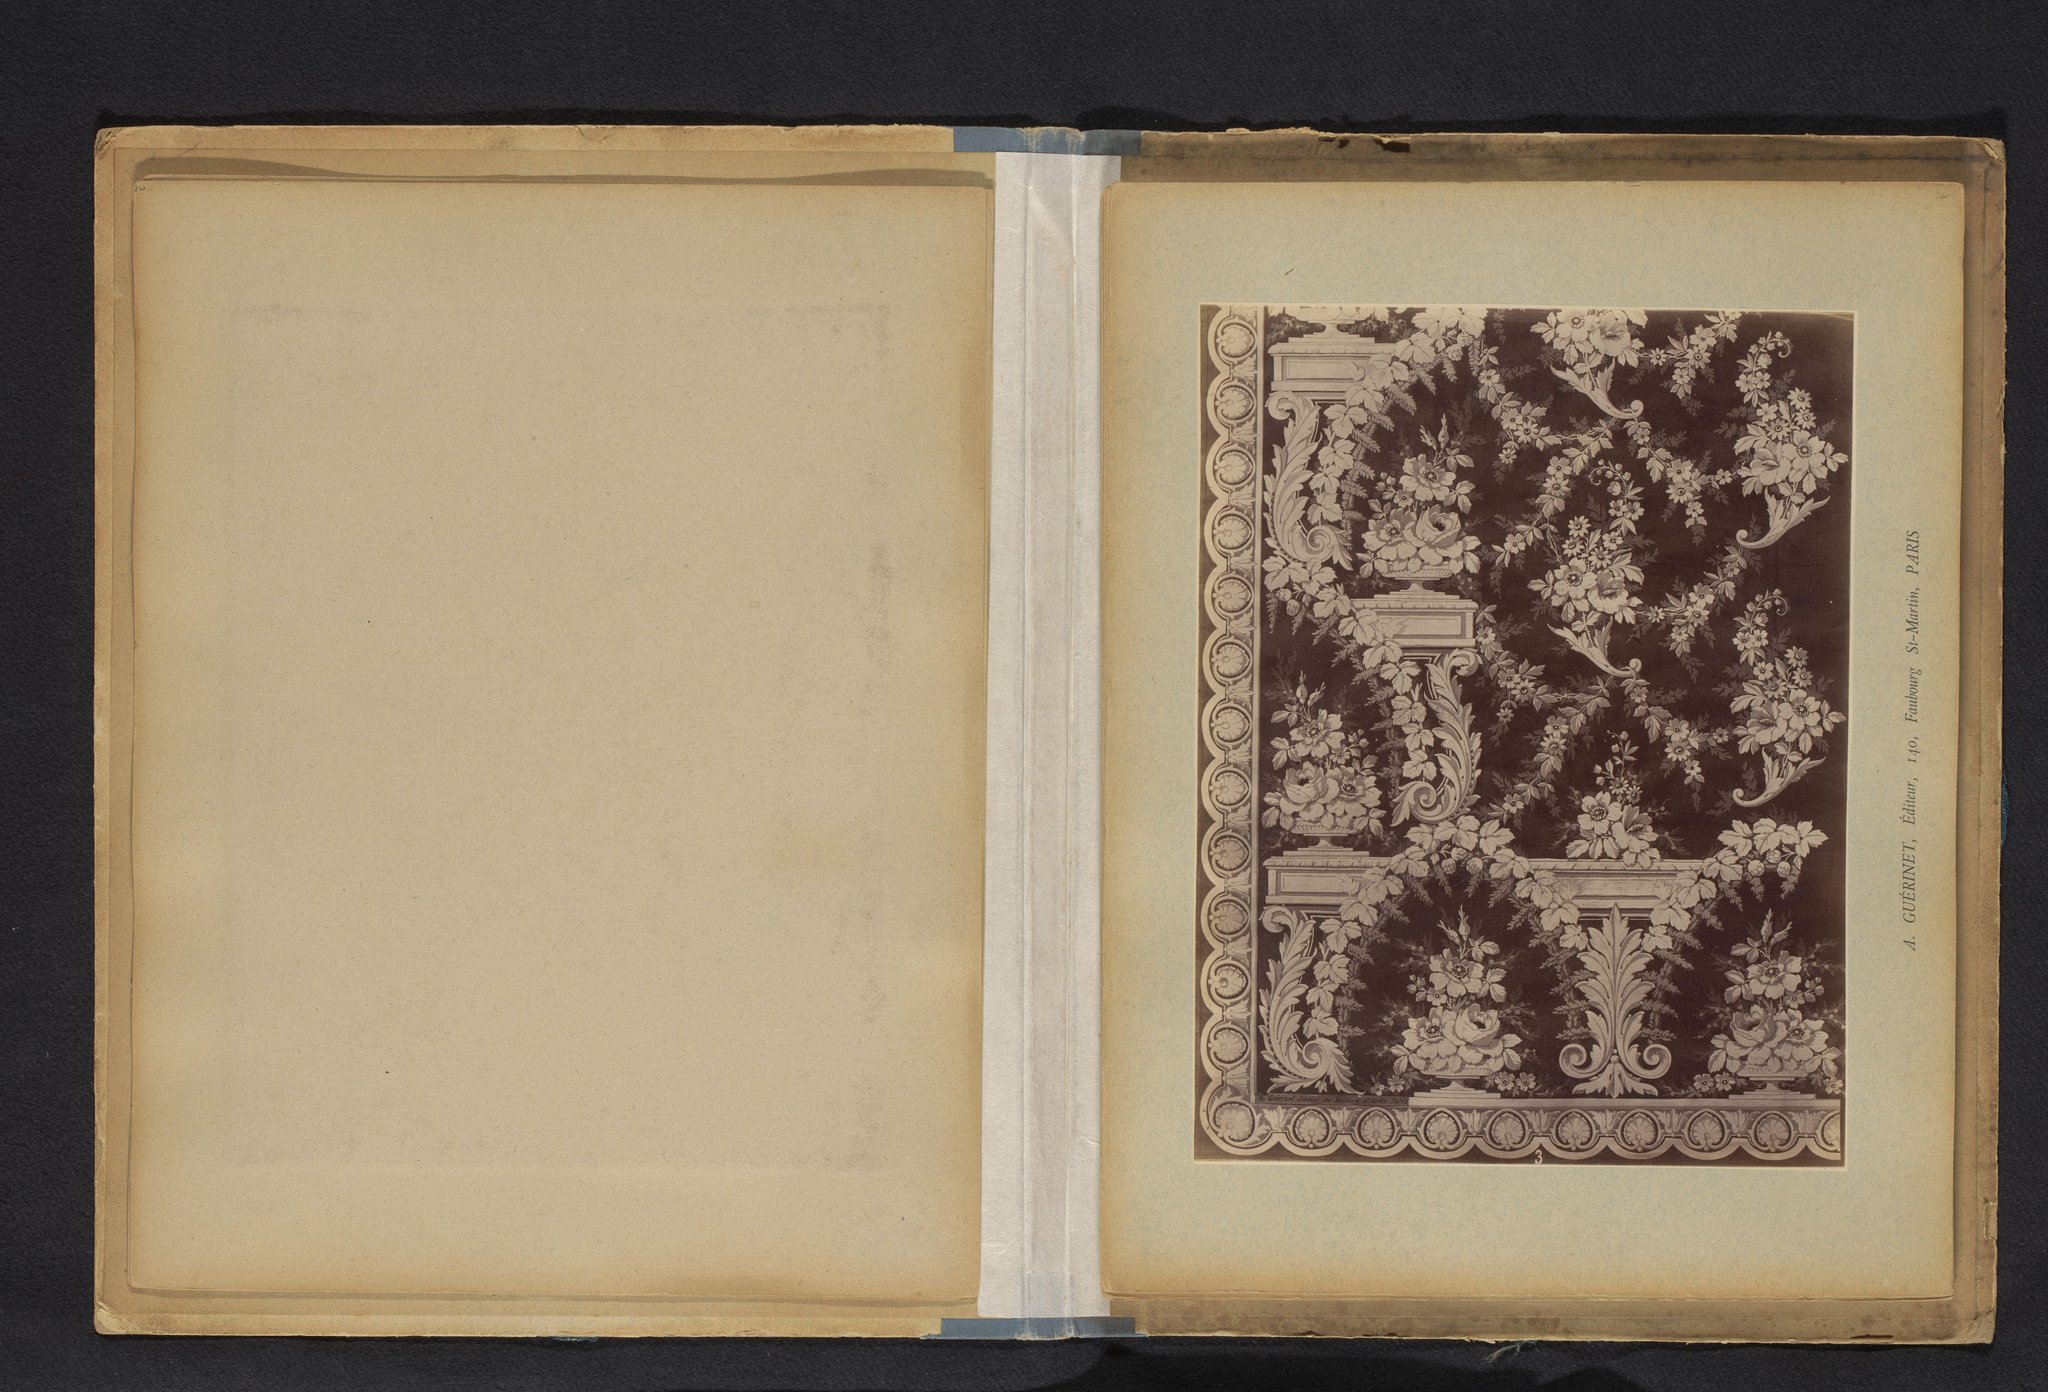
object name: photograph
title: Fotoreproductie van een decoratief bloemenpatroon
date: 1890-1900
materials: photographic support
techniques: albumen print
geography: paris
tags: flowers ~ ornament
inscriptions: number: ‘3’